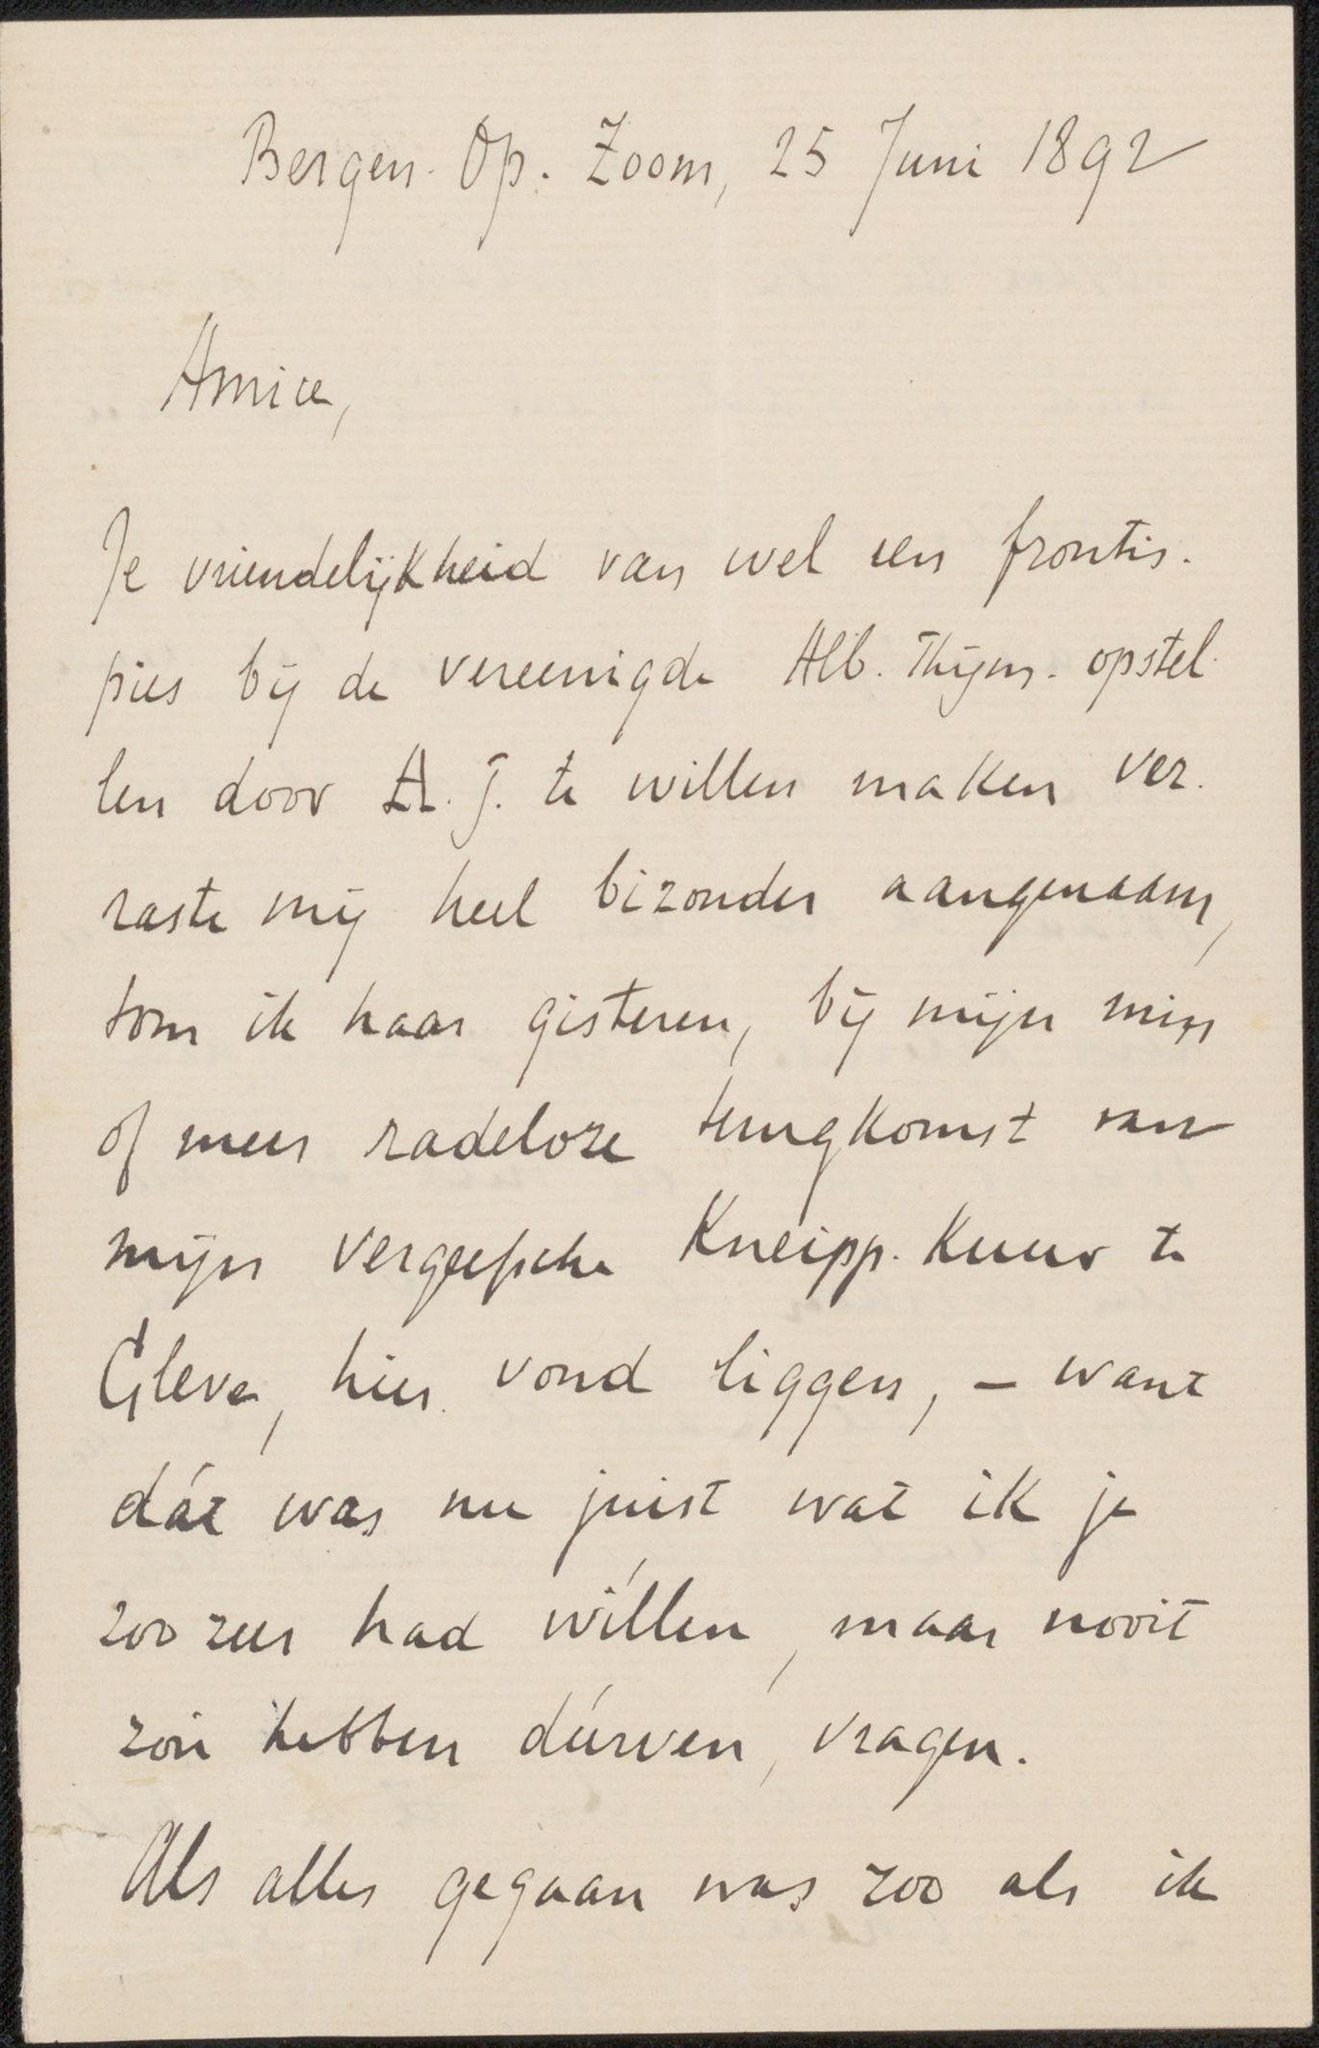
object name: letter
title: Brief aan Jan Veth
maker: karel johan lodewijk alberdingk thijm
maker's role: criticus, prozaschrijver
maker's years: 1864-1952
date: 1892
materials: ink, paper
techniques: pen, writing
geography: bergen op zoom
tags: dordrecht, amsterdam, painter, print maker, draughtsman, designer, jan veth, den bosch, antoon derkinderen, publisher, josephus albertus alberdingk thijm, illustration ~ printed matter, book, diseases, printed matter, cleves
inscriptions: collector's mark: ‘RPK’